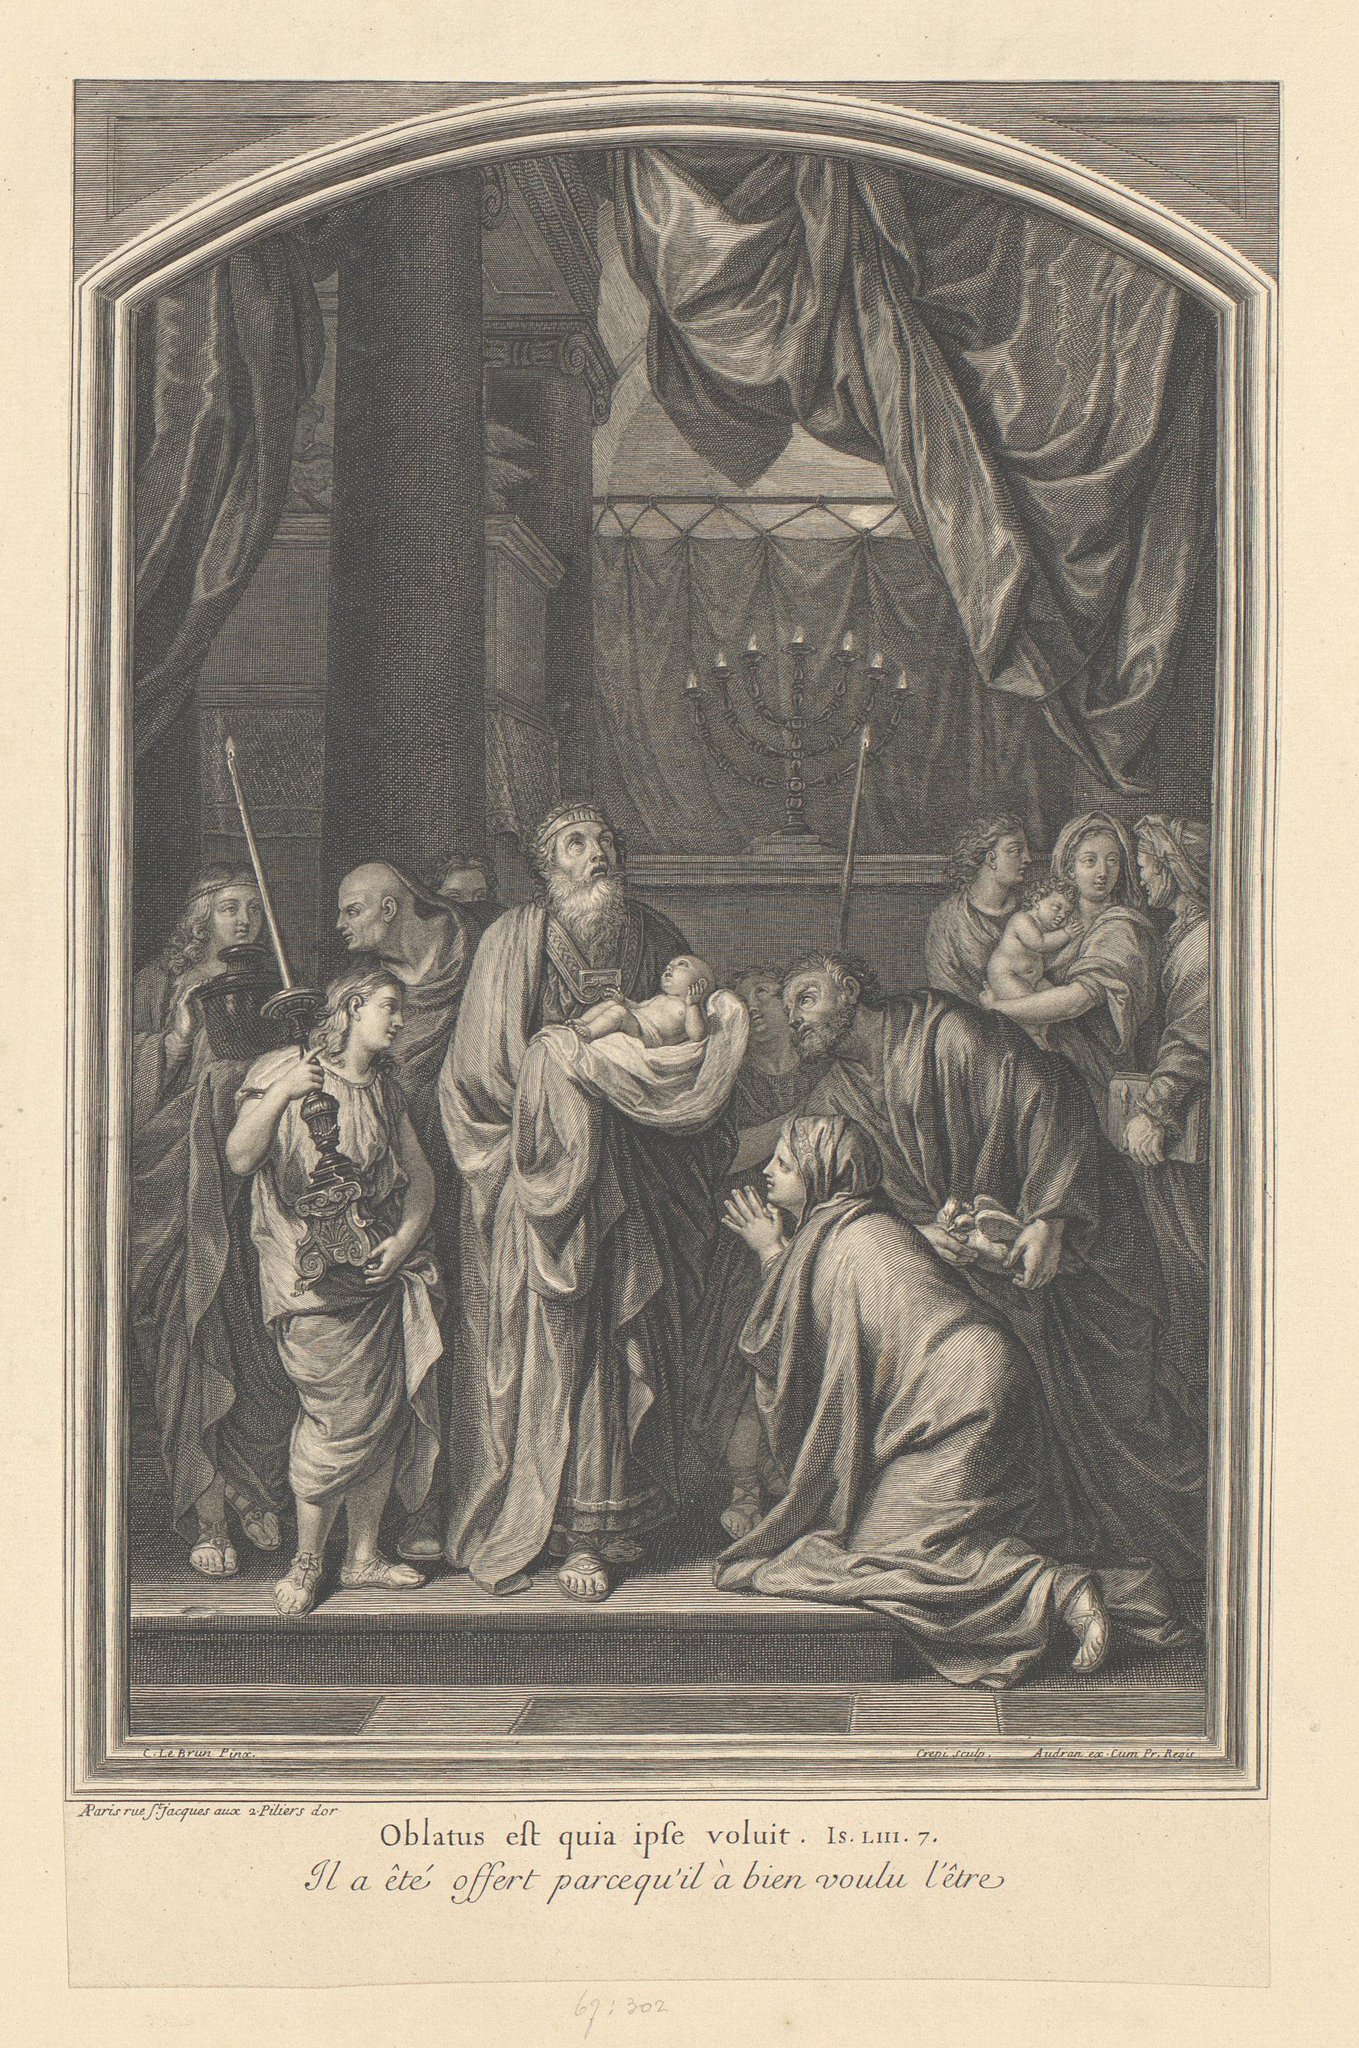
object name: print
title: Werken van Charles le Brun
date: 1670-1730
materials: paper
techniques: engraving, etching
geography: paris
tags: presentation of the christ-child in the temple, usually simeon (and anna) present (luke 2:22-39)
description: Deze prent maakt deel uit van een album.